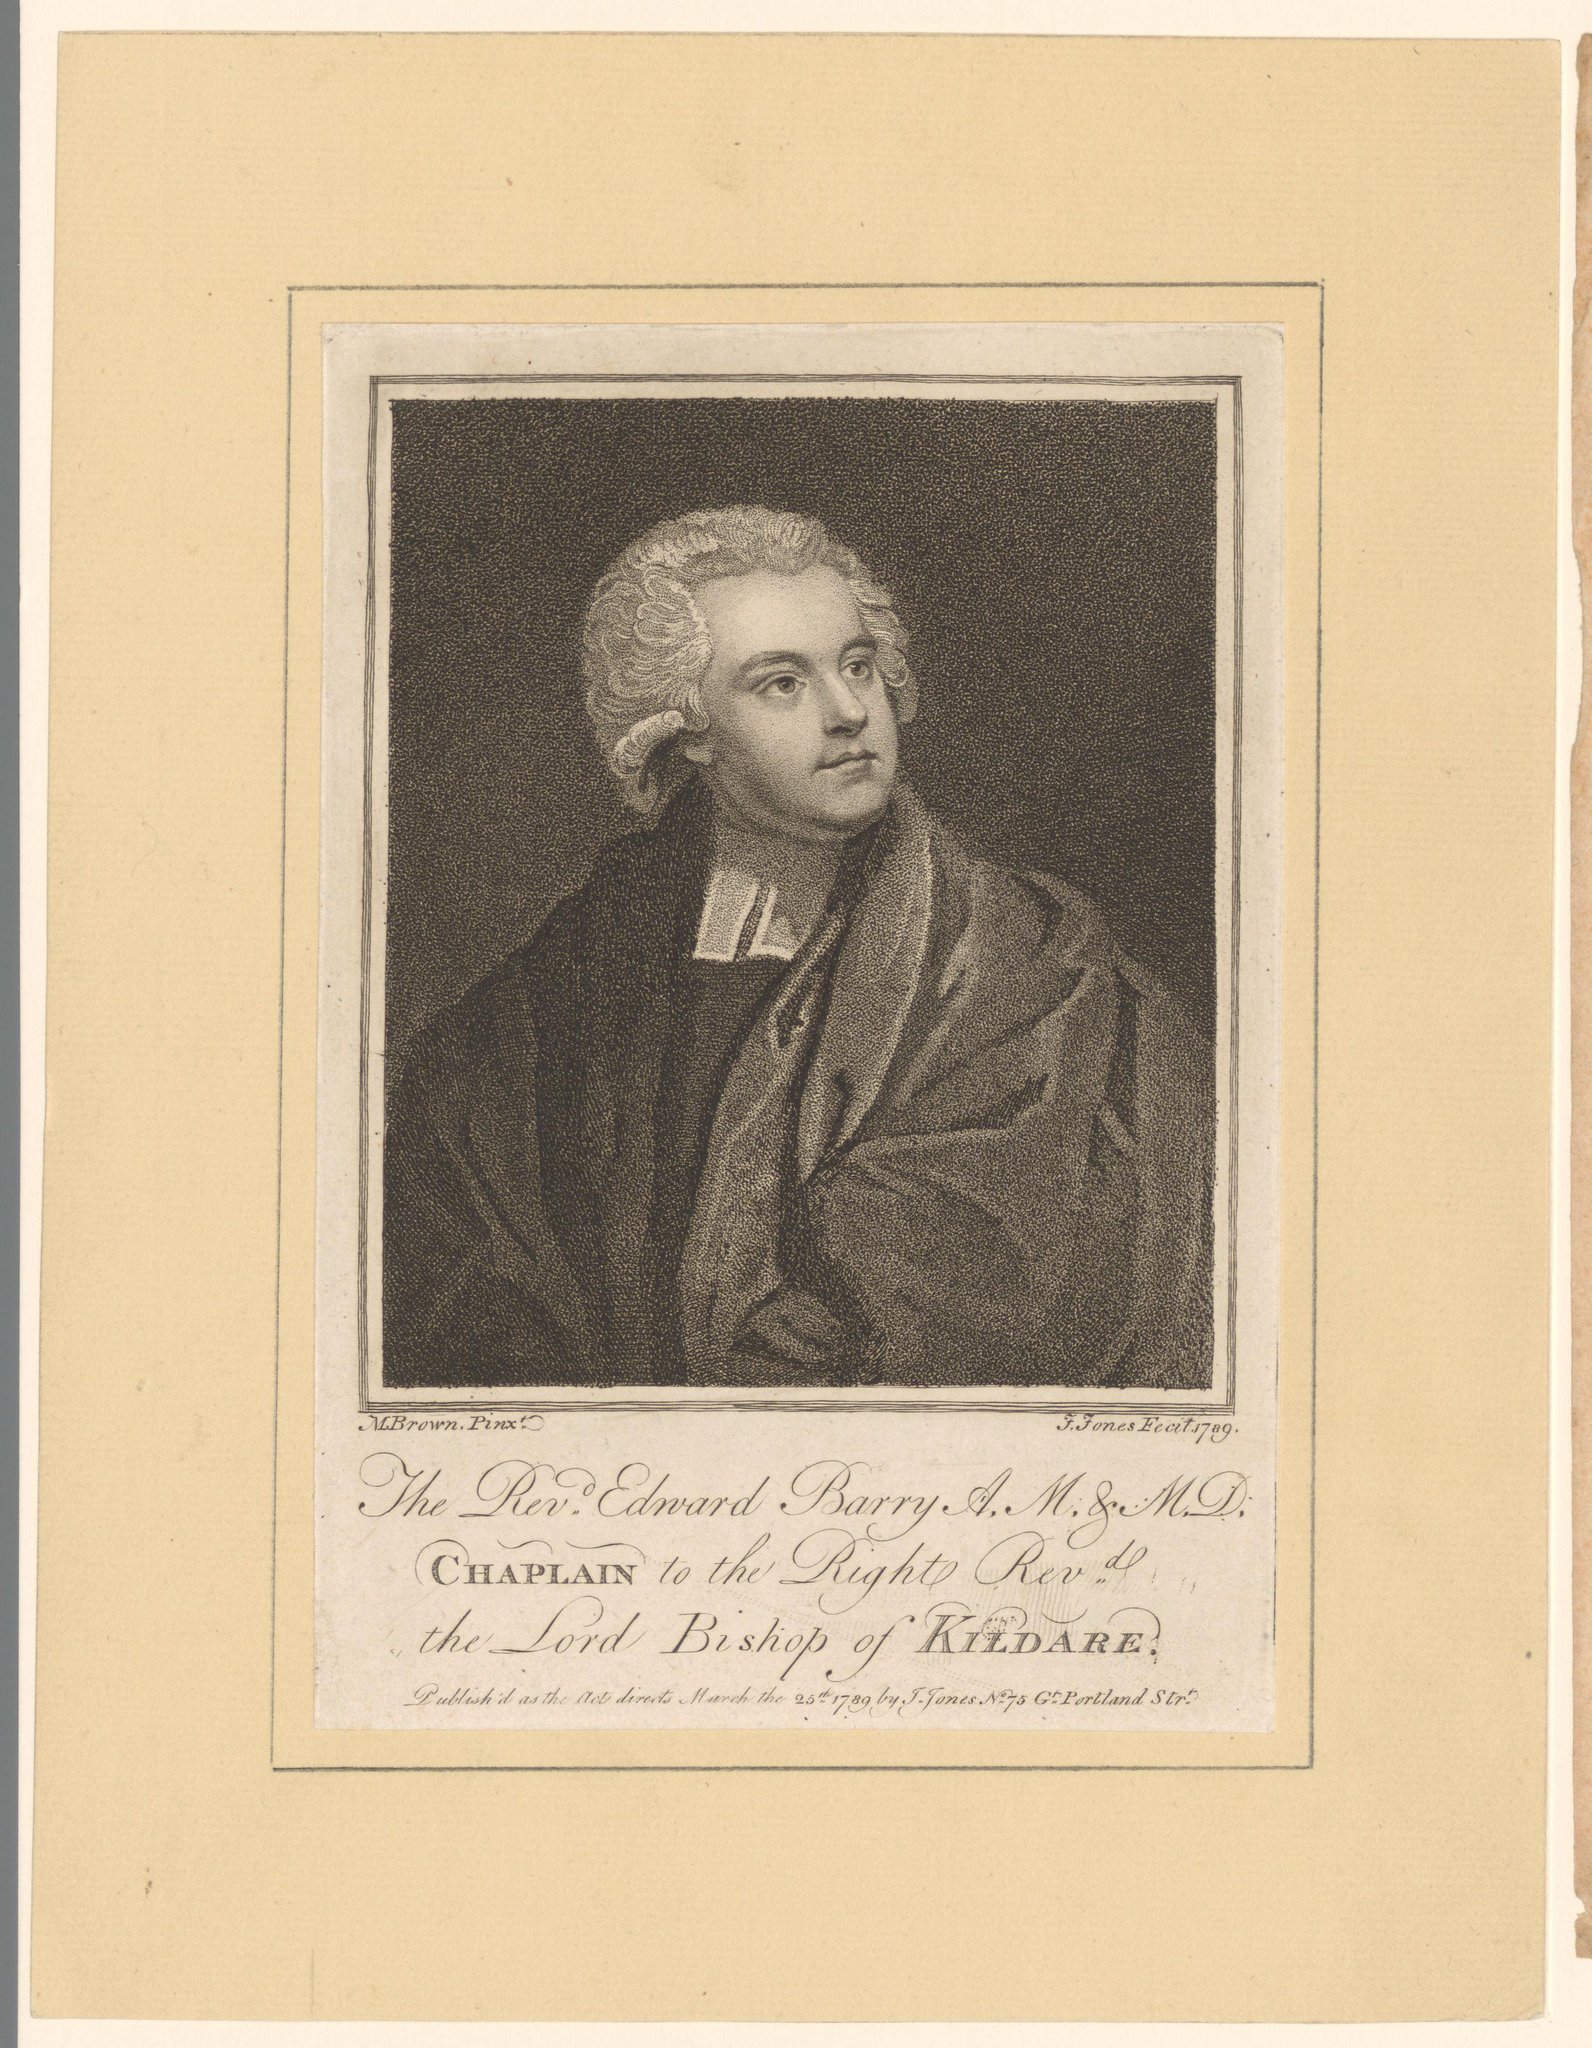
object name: print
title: Portret van Edward Barry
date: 1789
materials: paper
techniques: etching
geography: london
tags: theologian, historical persons, portrait of a writer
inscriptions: collector's mark: Lugt 2228